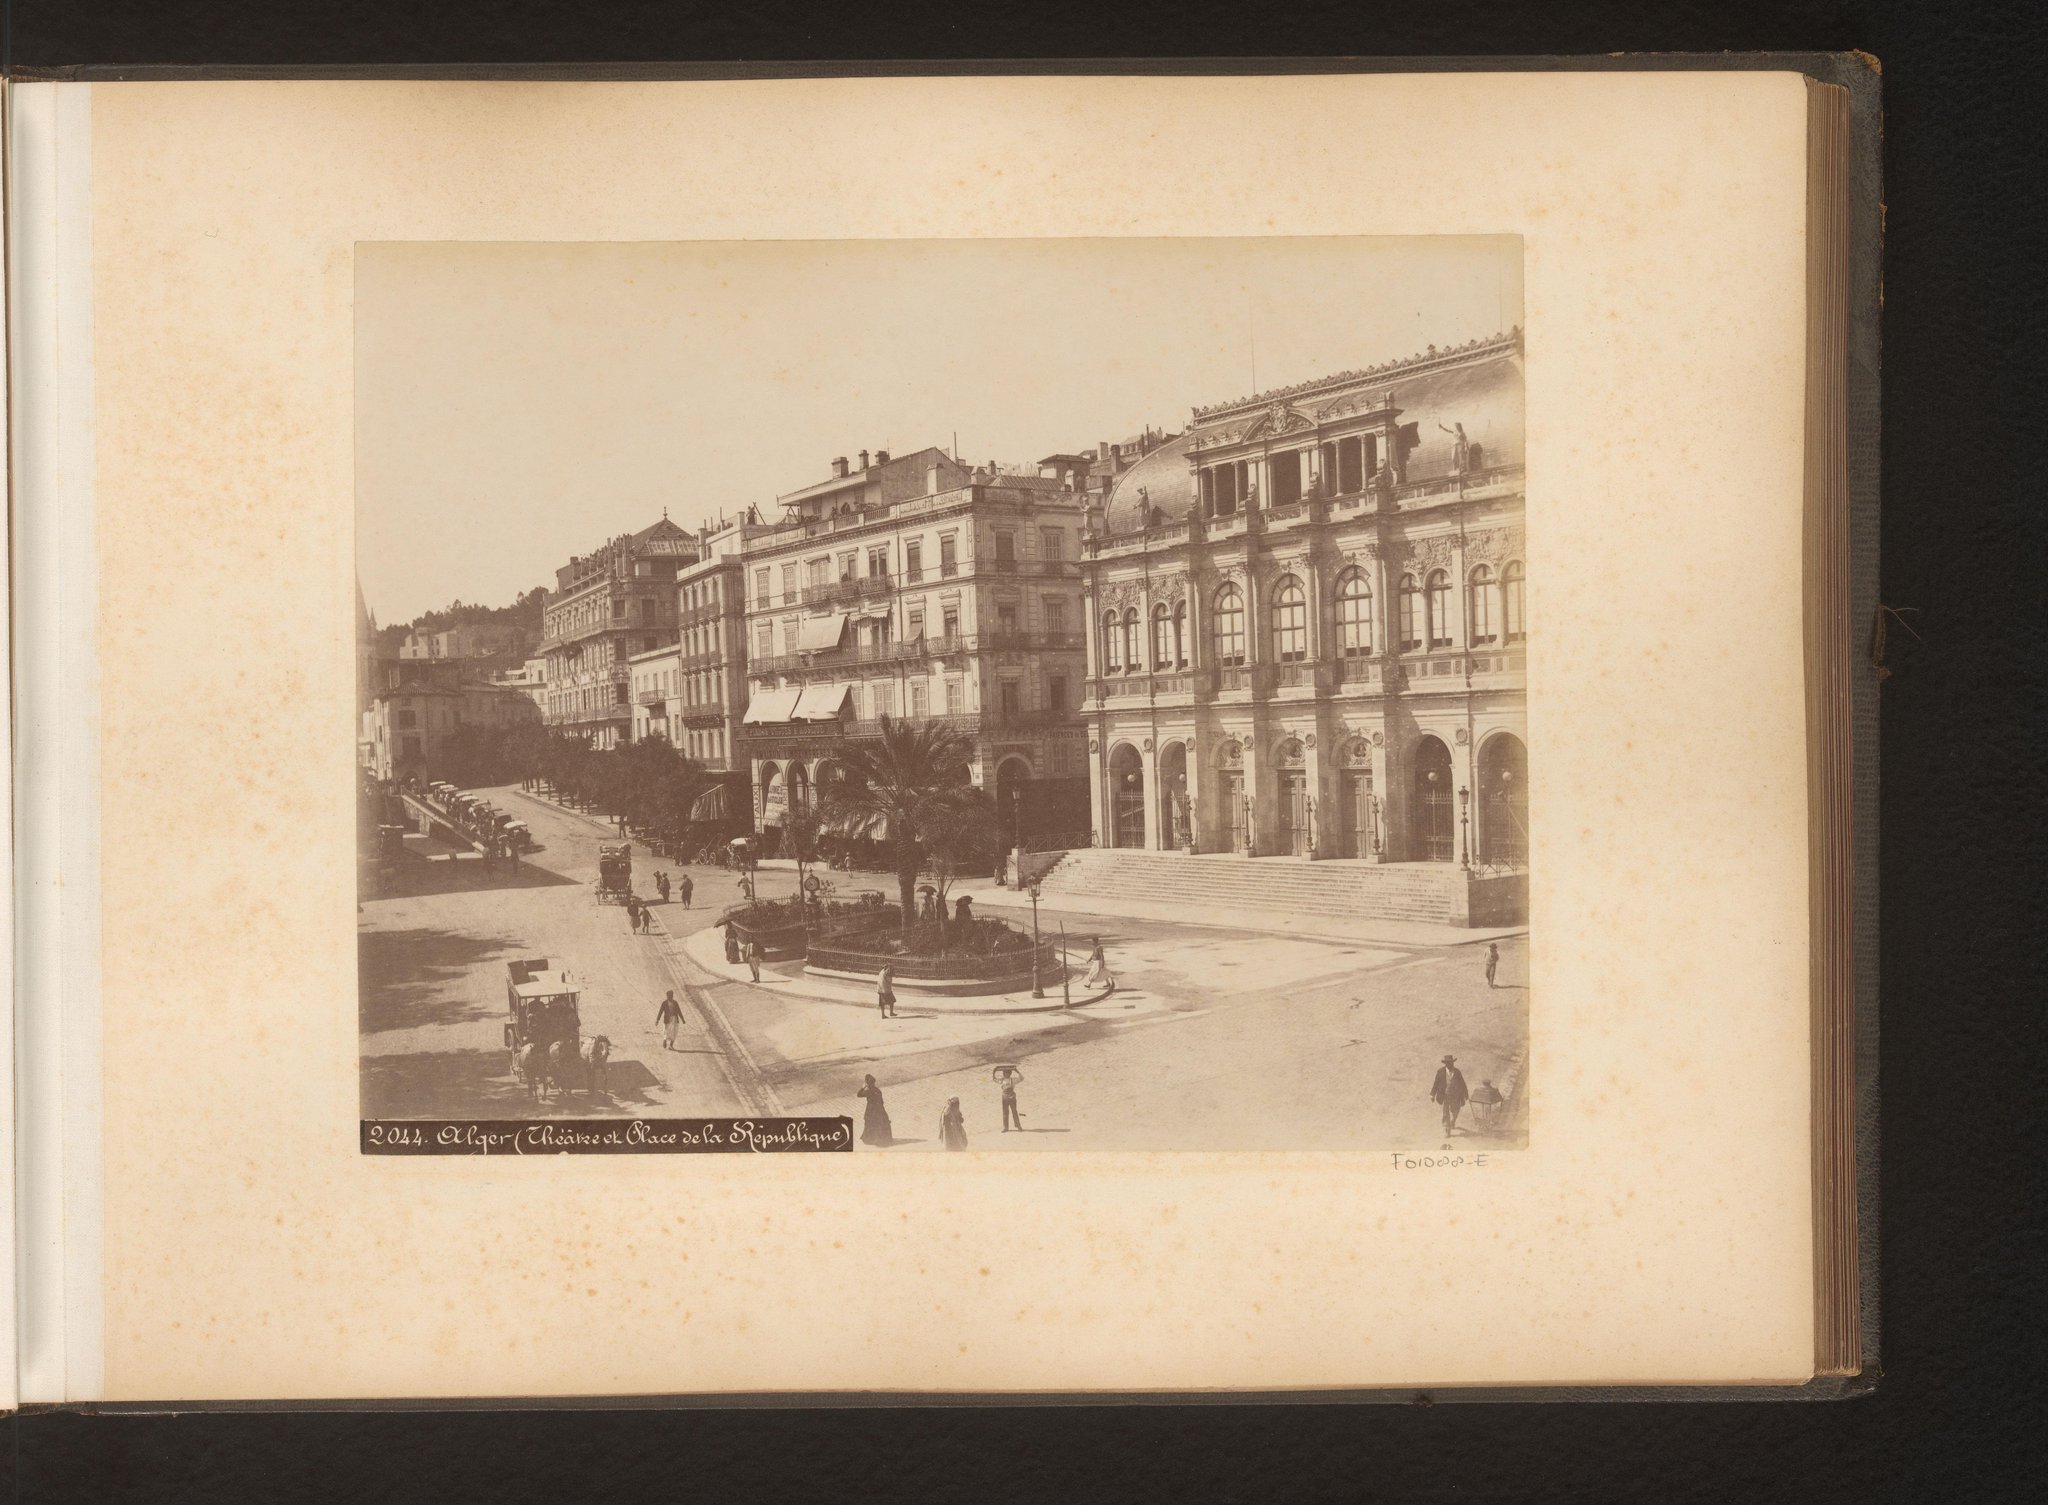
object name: photograph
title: Alger (Theatre et Place de la Republique)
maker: Anonymous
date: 1875-1885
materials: photographic support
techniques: albumen print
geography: algiers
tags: square, place, circus, etc. (+ city(-scape) with figures, staffage)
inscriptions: number: ‘2044’